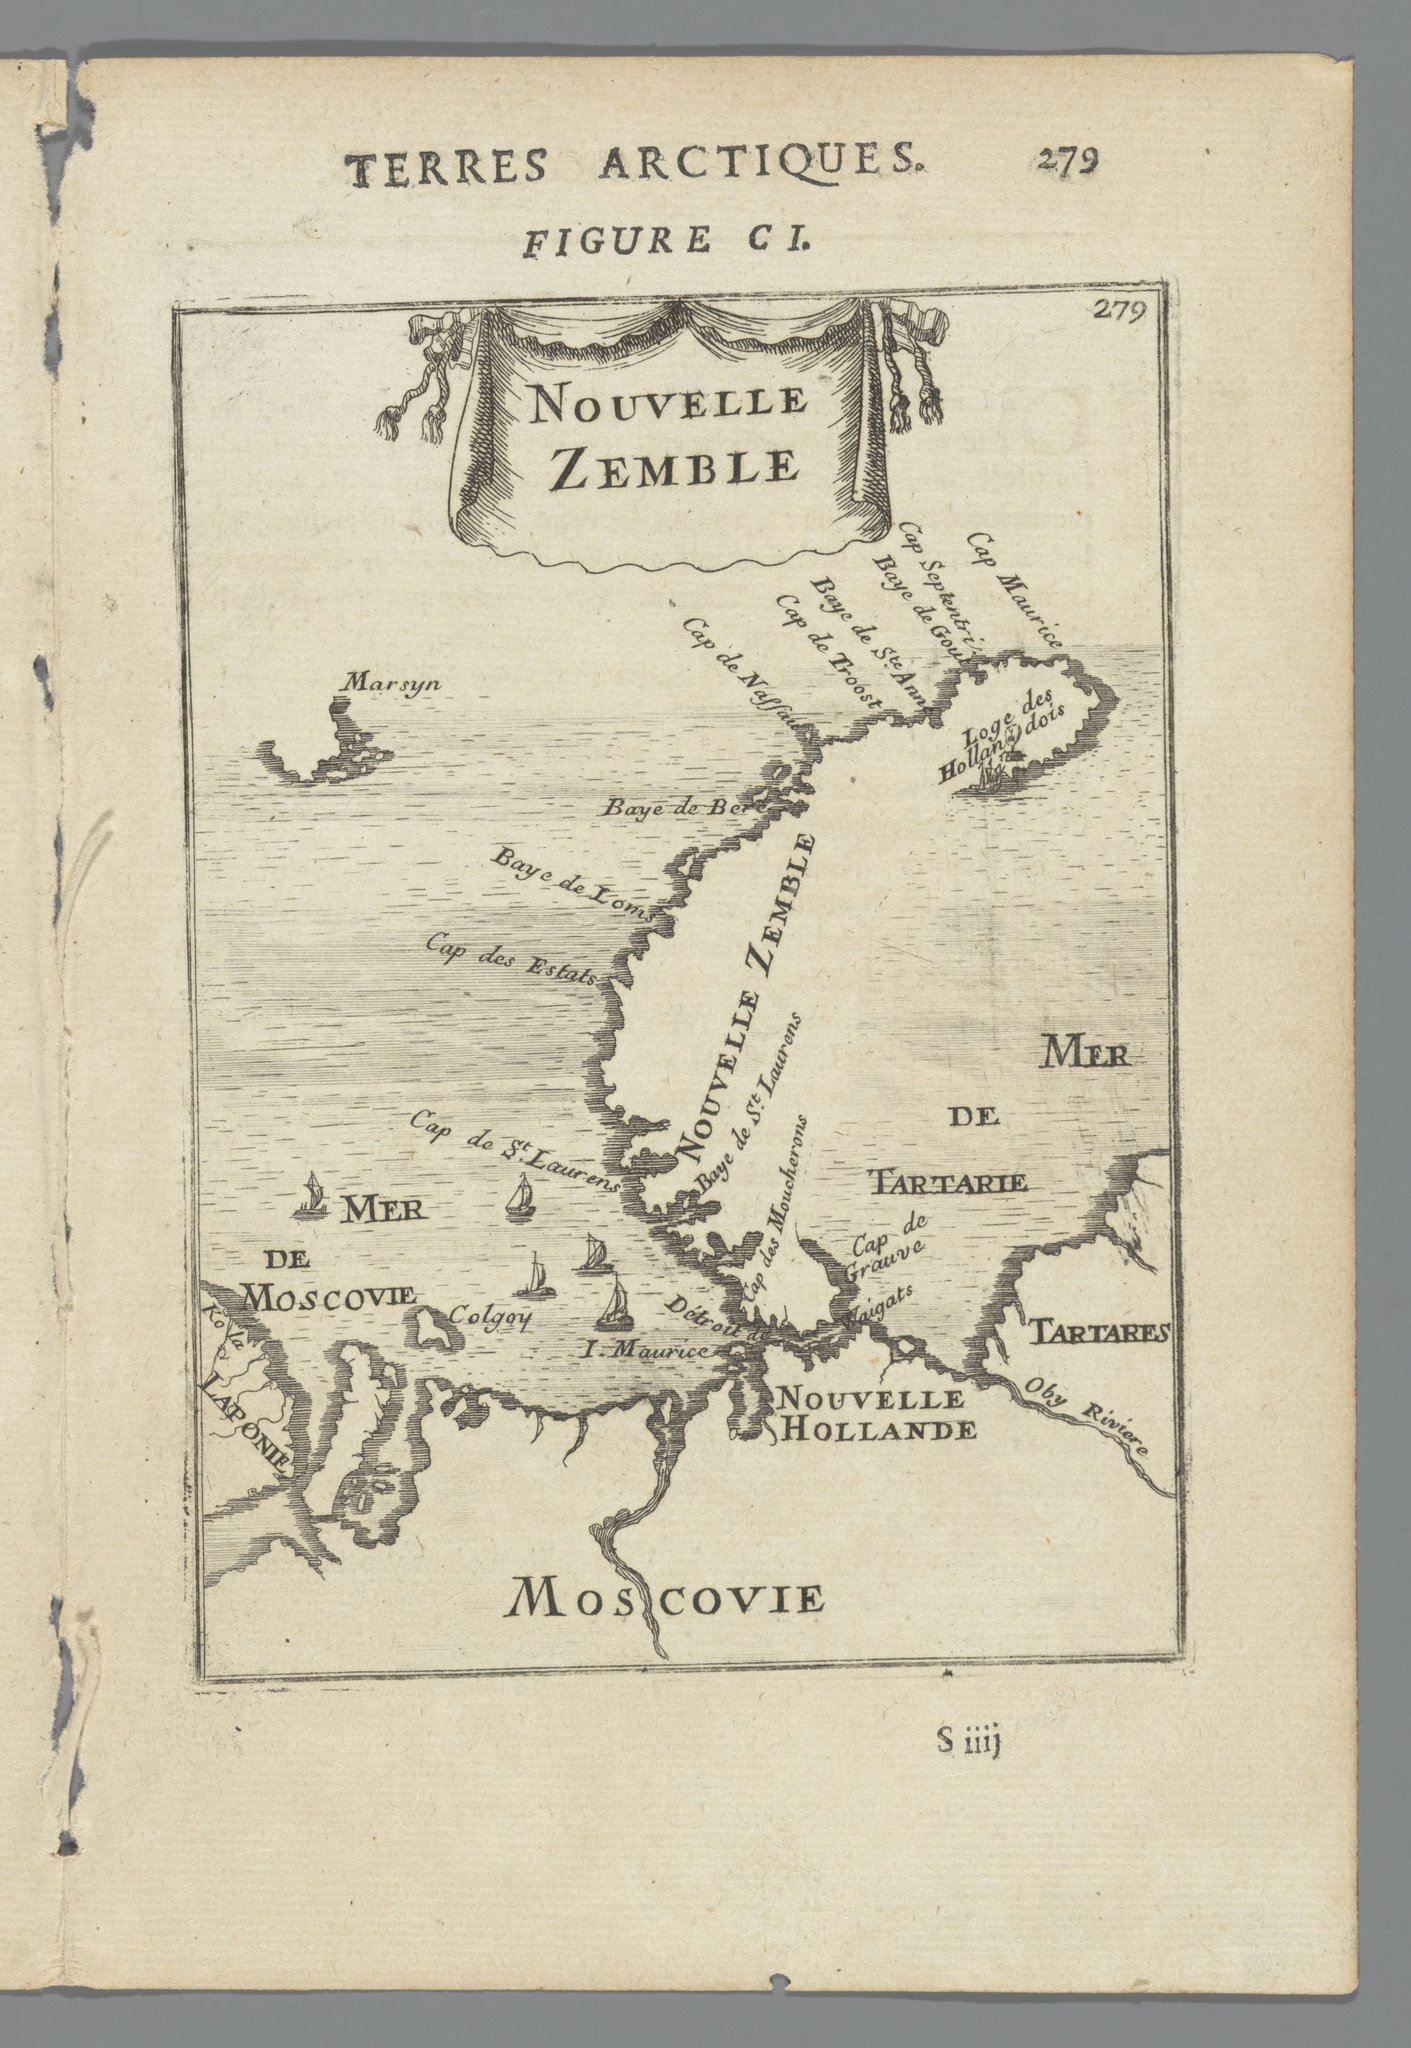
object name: page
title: Terre Arctiques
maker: Anonymous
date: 1600-1699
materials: paper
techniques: printing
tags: willem barendsz.